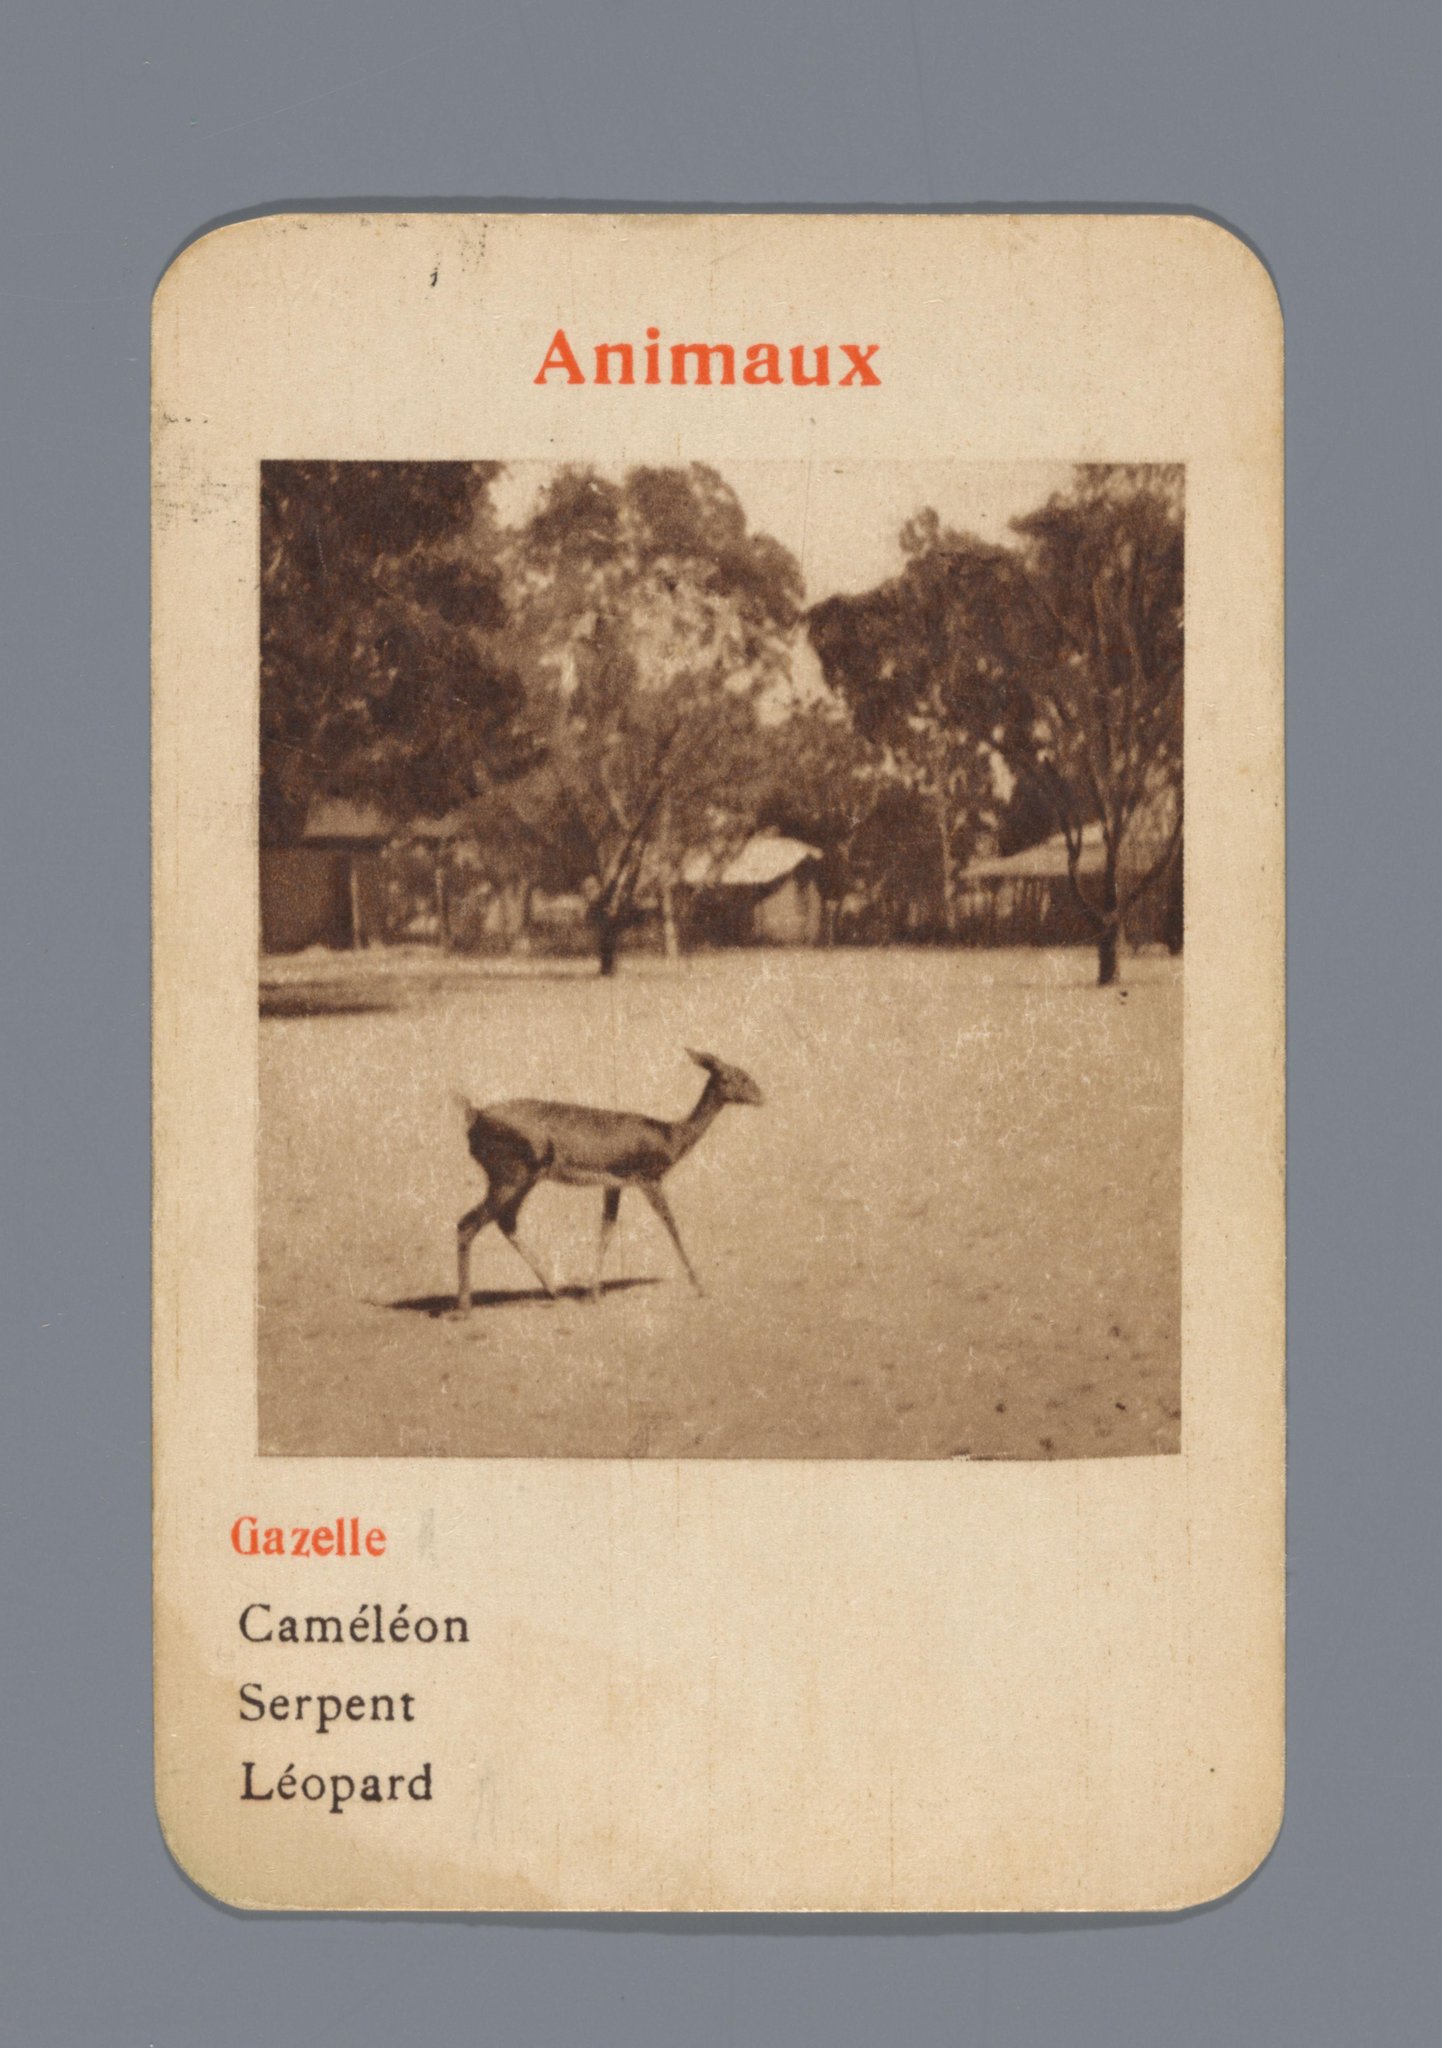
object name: photomechanical print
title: Gazelle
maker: Anonymous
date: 1900-1920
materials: cardboard, paper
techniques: rotogravure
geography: france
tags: card games, hoofed animals: gazelle